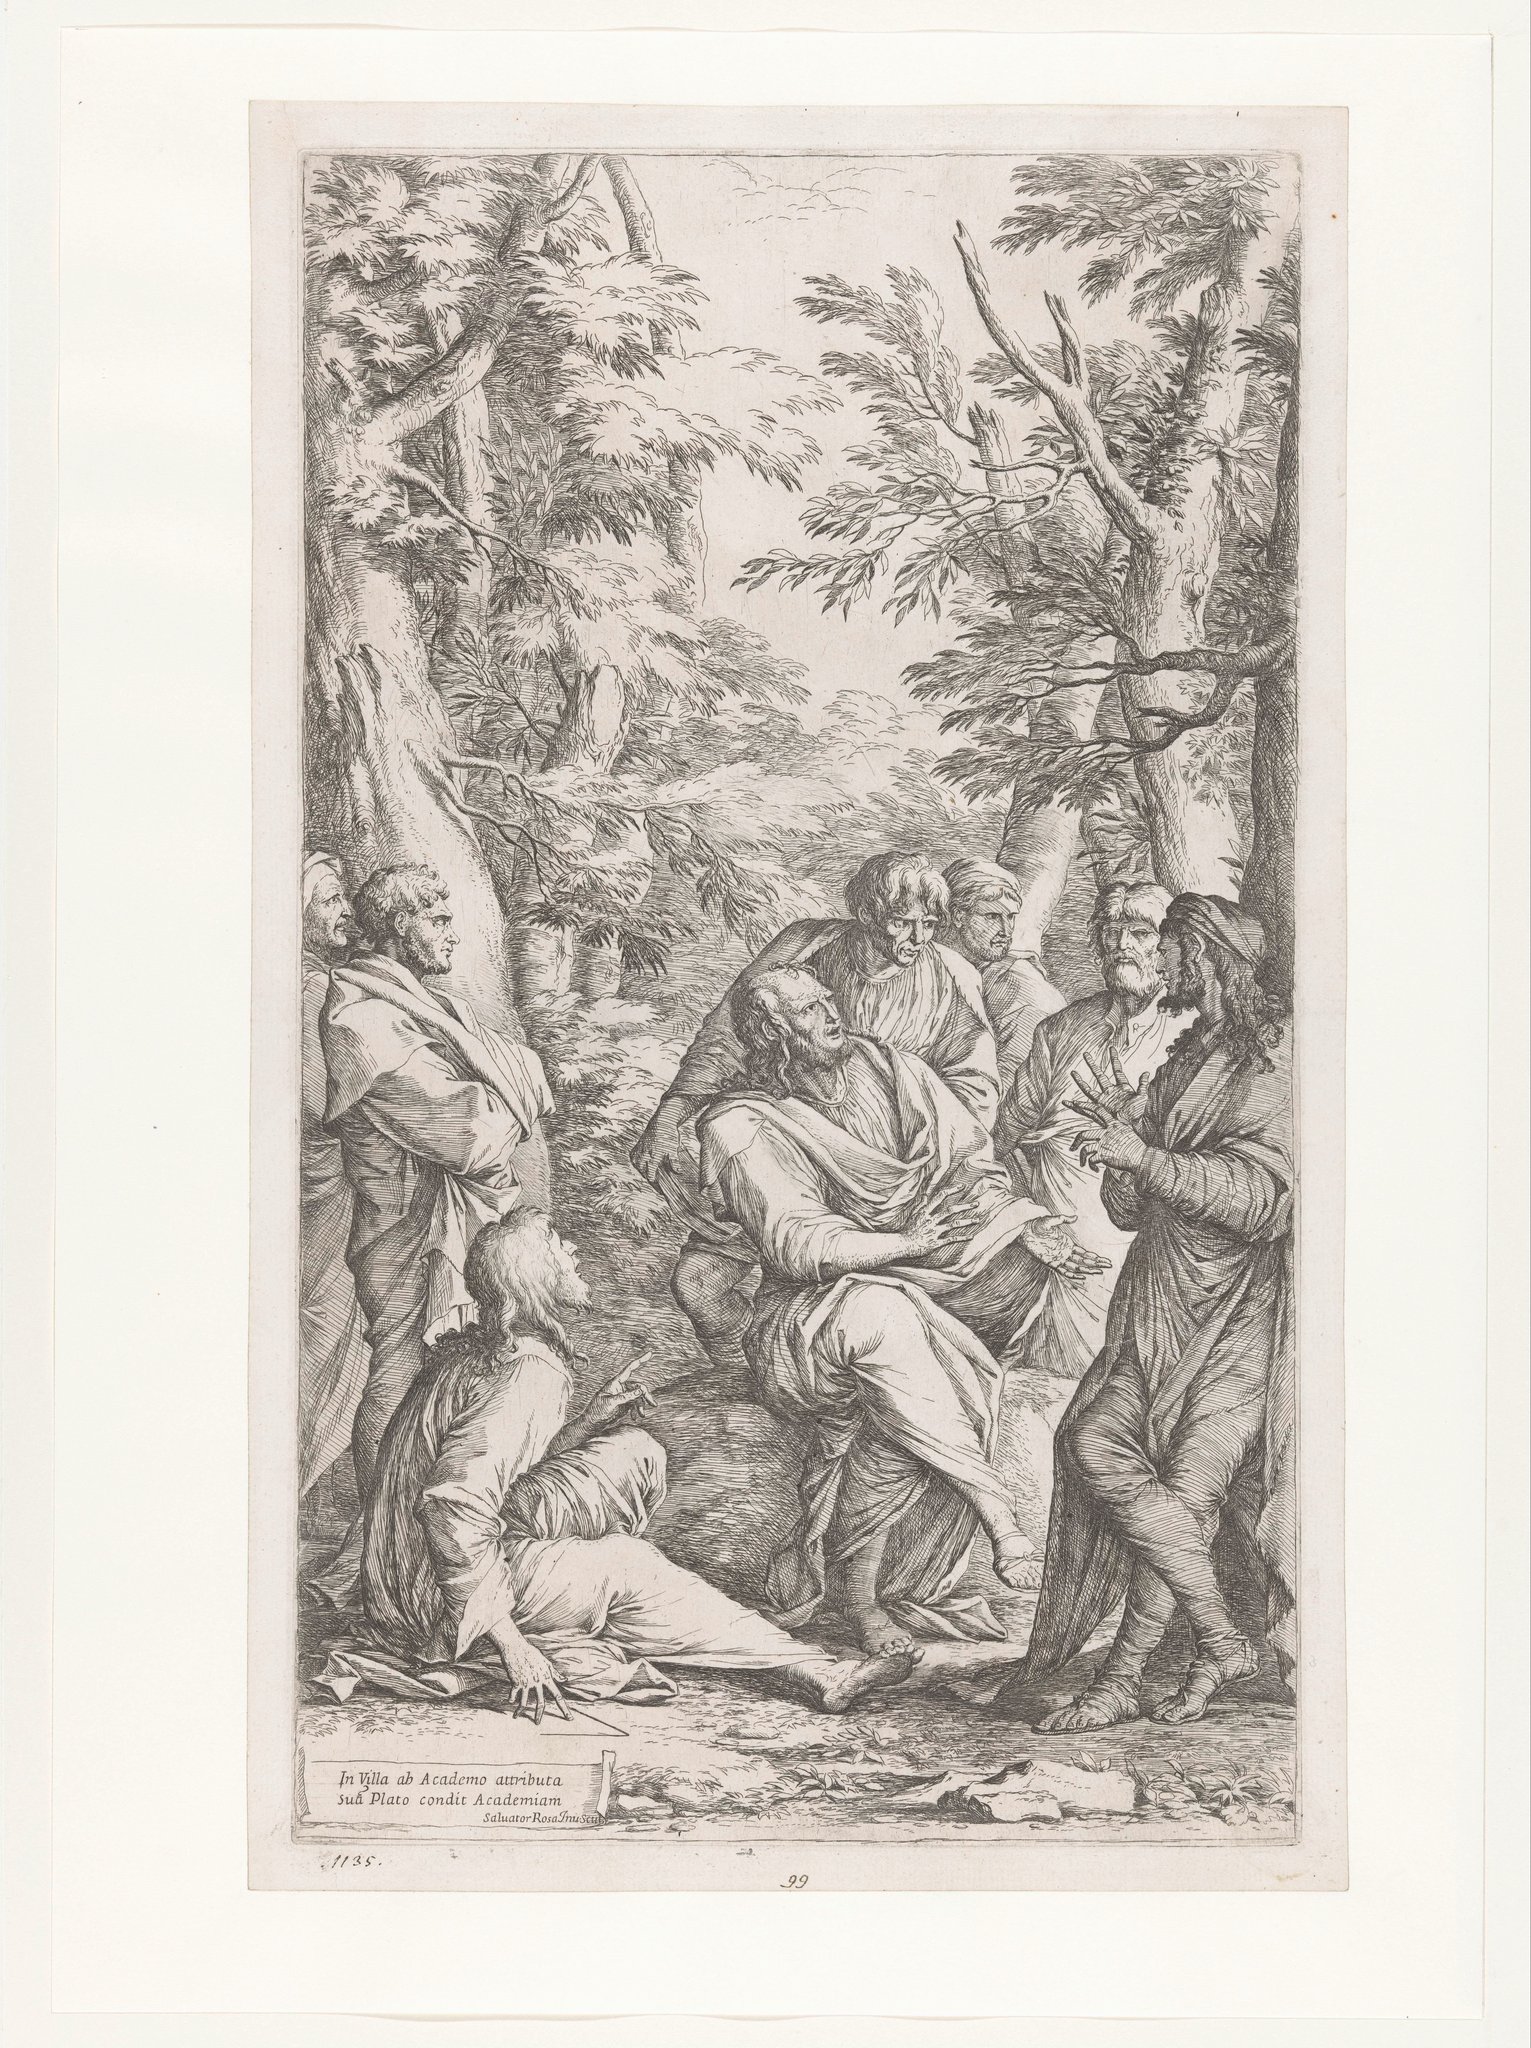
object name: print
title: Academie van Plato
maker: salvator rosa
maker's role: draughtsman, painter, print maker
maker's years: 1615-1673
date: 1662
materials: paper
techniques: drypoint, etching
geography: italy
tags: debate, discussion (~ meeting), philosophy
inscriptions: number: ‘1135 99’, collector's mark: Lugt 240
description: Verscheidene voorstudies voor figuren op deze prent zijn bewaard gebleven en bevinden zich in diverse collecties. Een tekening in het British Museum is mogelijk de laatste voorstudie die is gebruikt voor deze prent(inv.nr. 1855,0714.54).